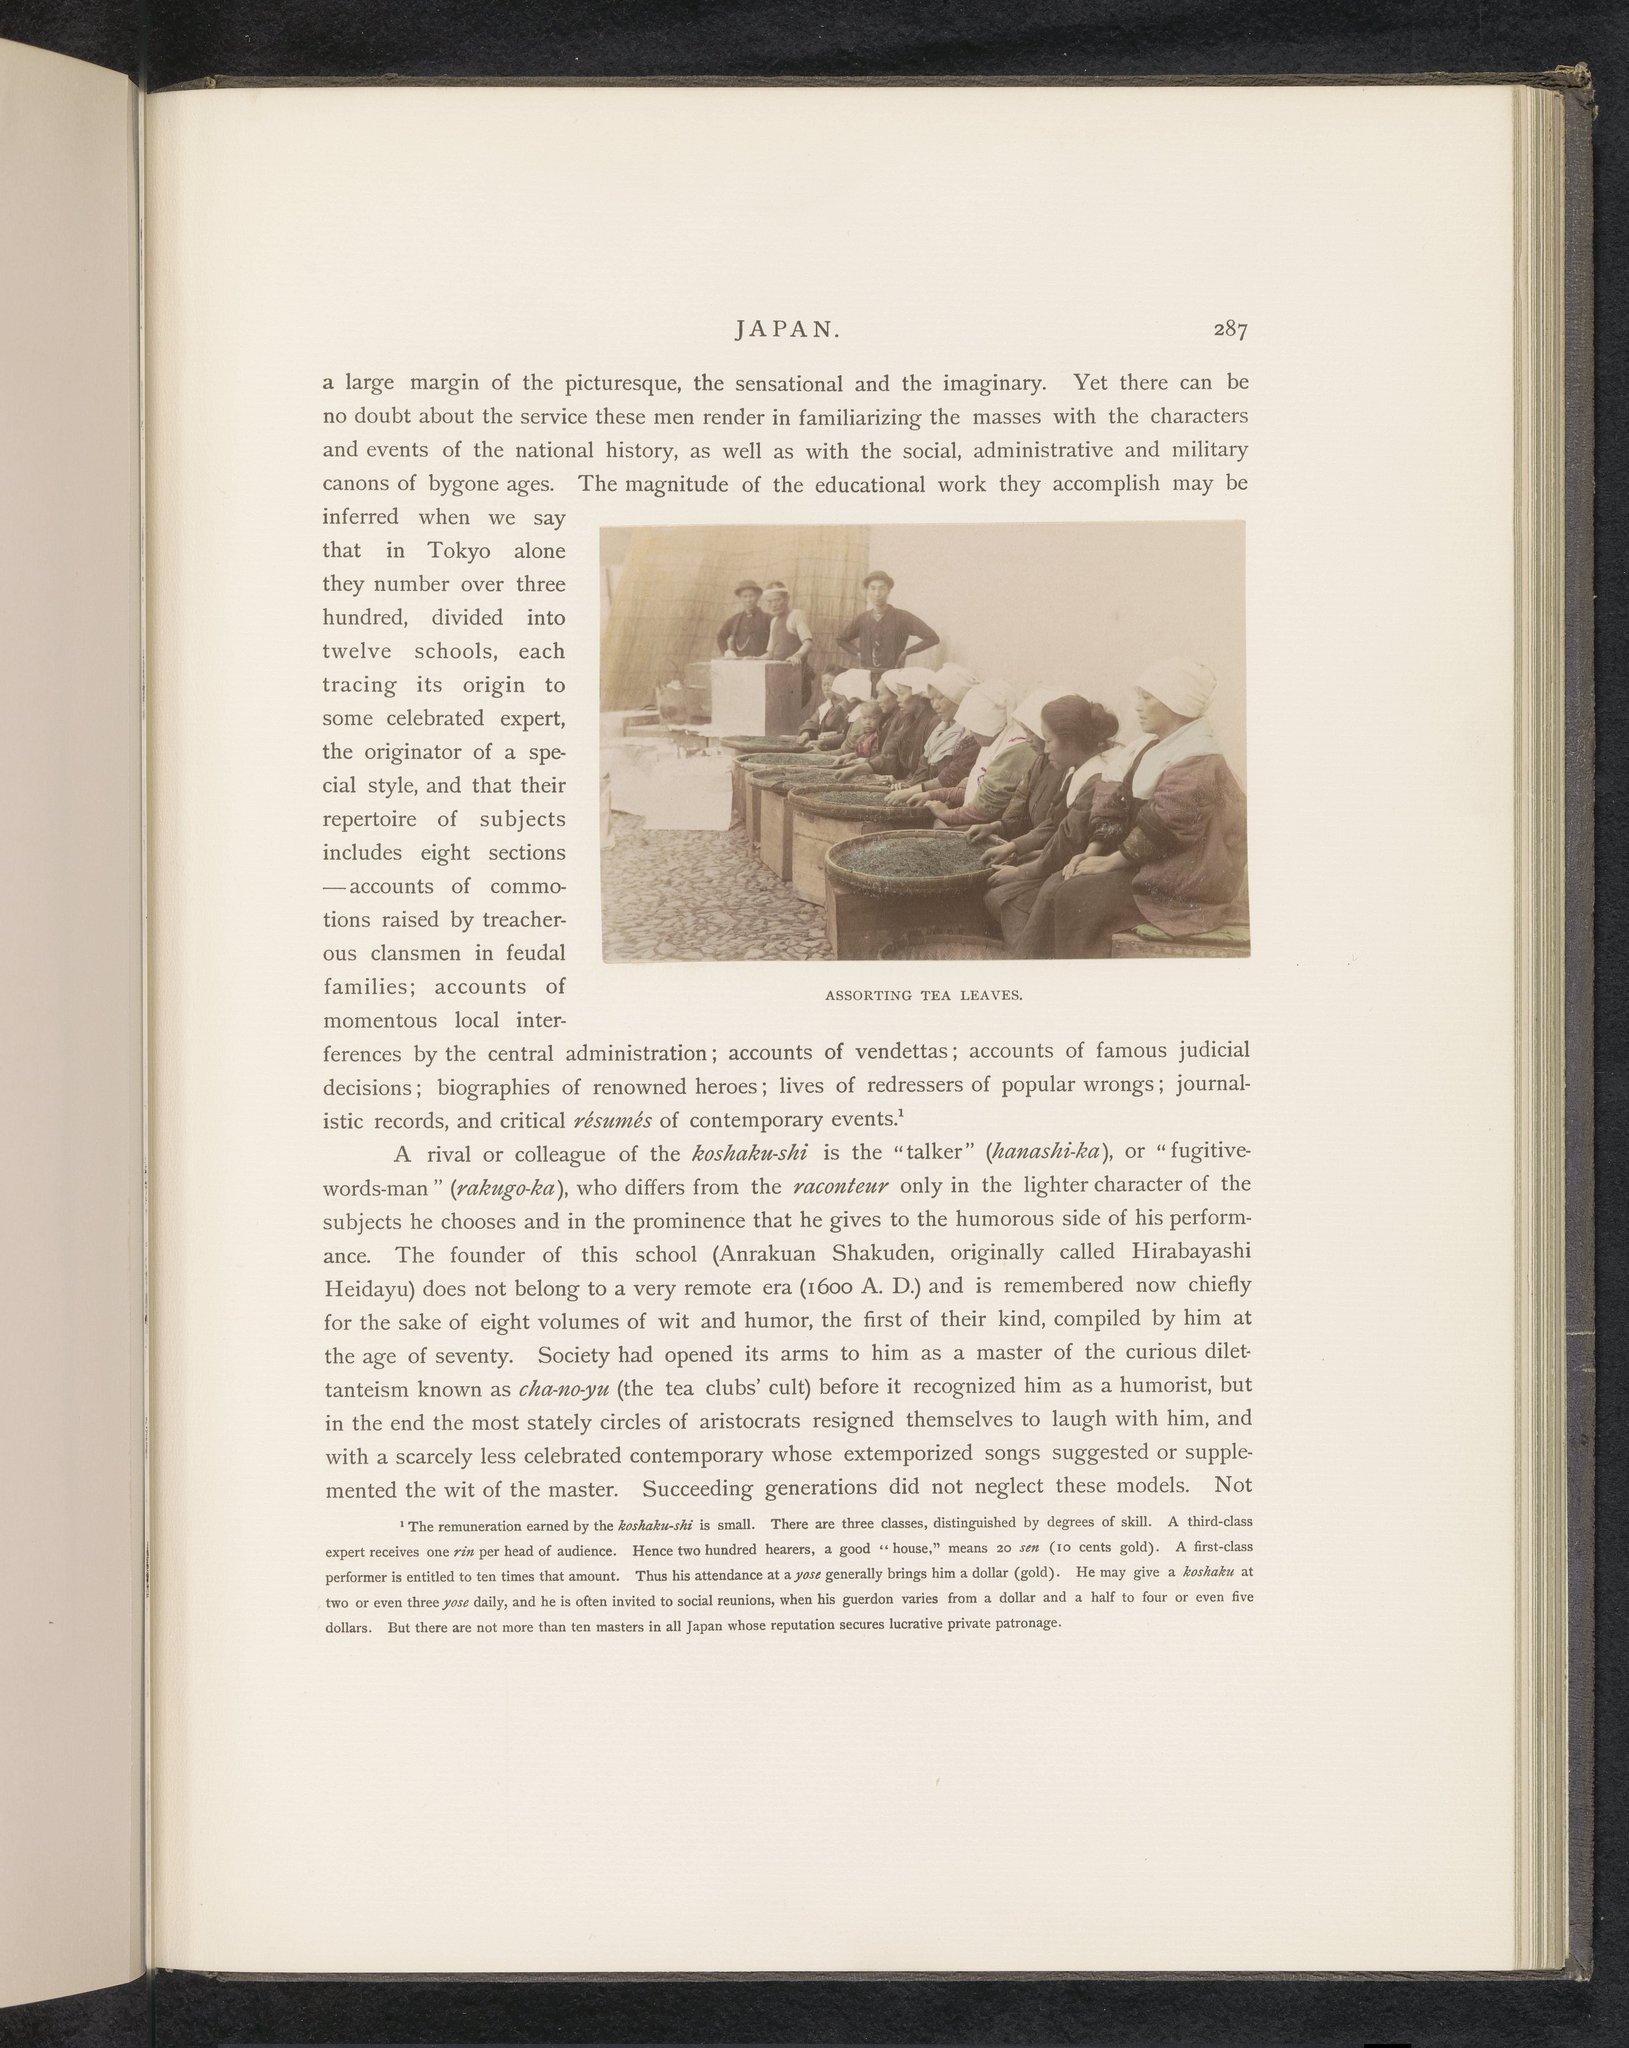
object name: photograph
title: Assorting tea leaves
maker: Anonymous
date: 1887-1897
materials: photographic support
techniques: albumen print, hand coloring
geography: japan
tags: wooden container: barrel, cask, bucket, working class, labourers, tea (leaves)